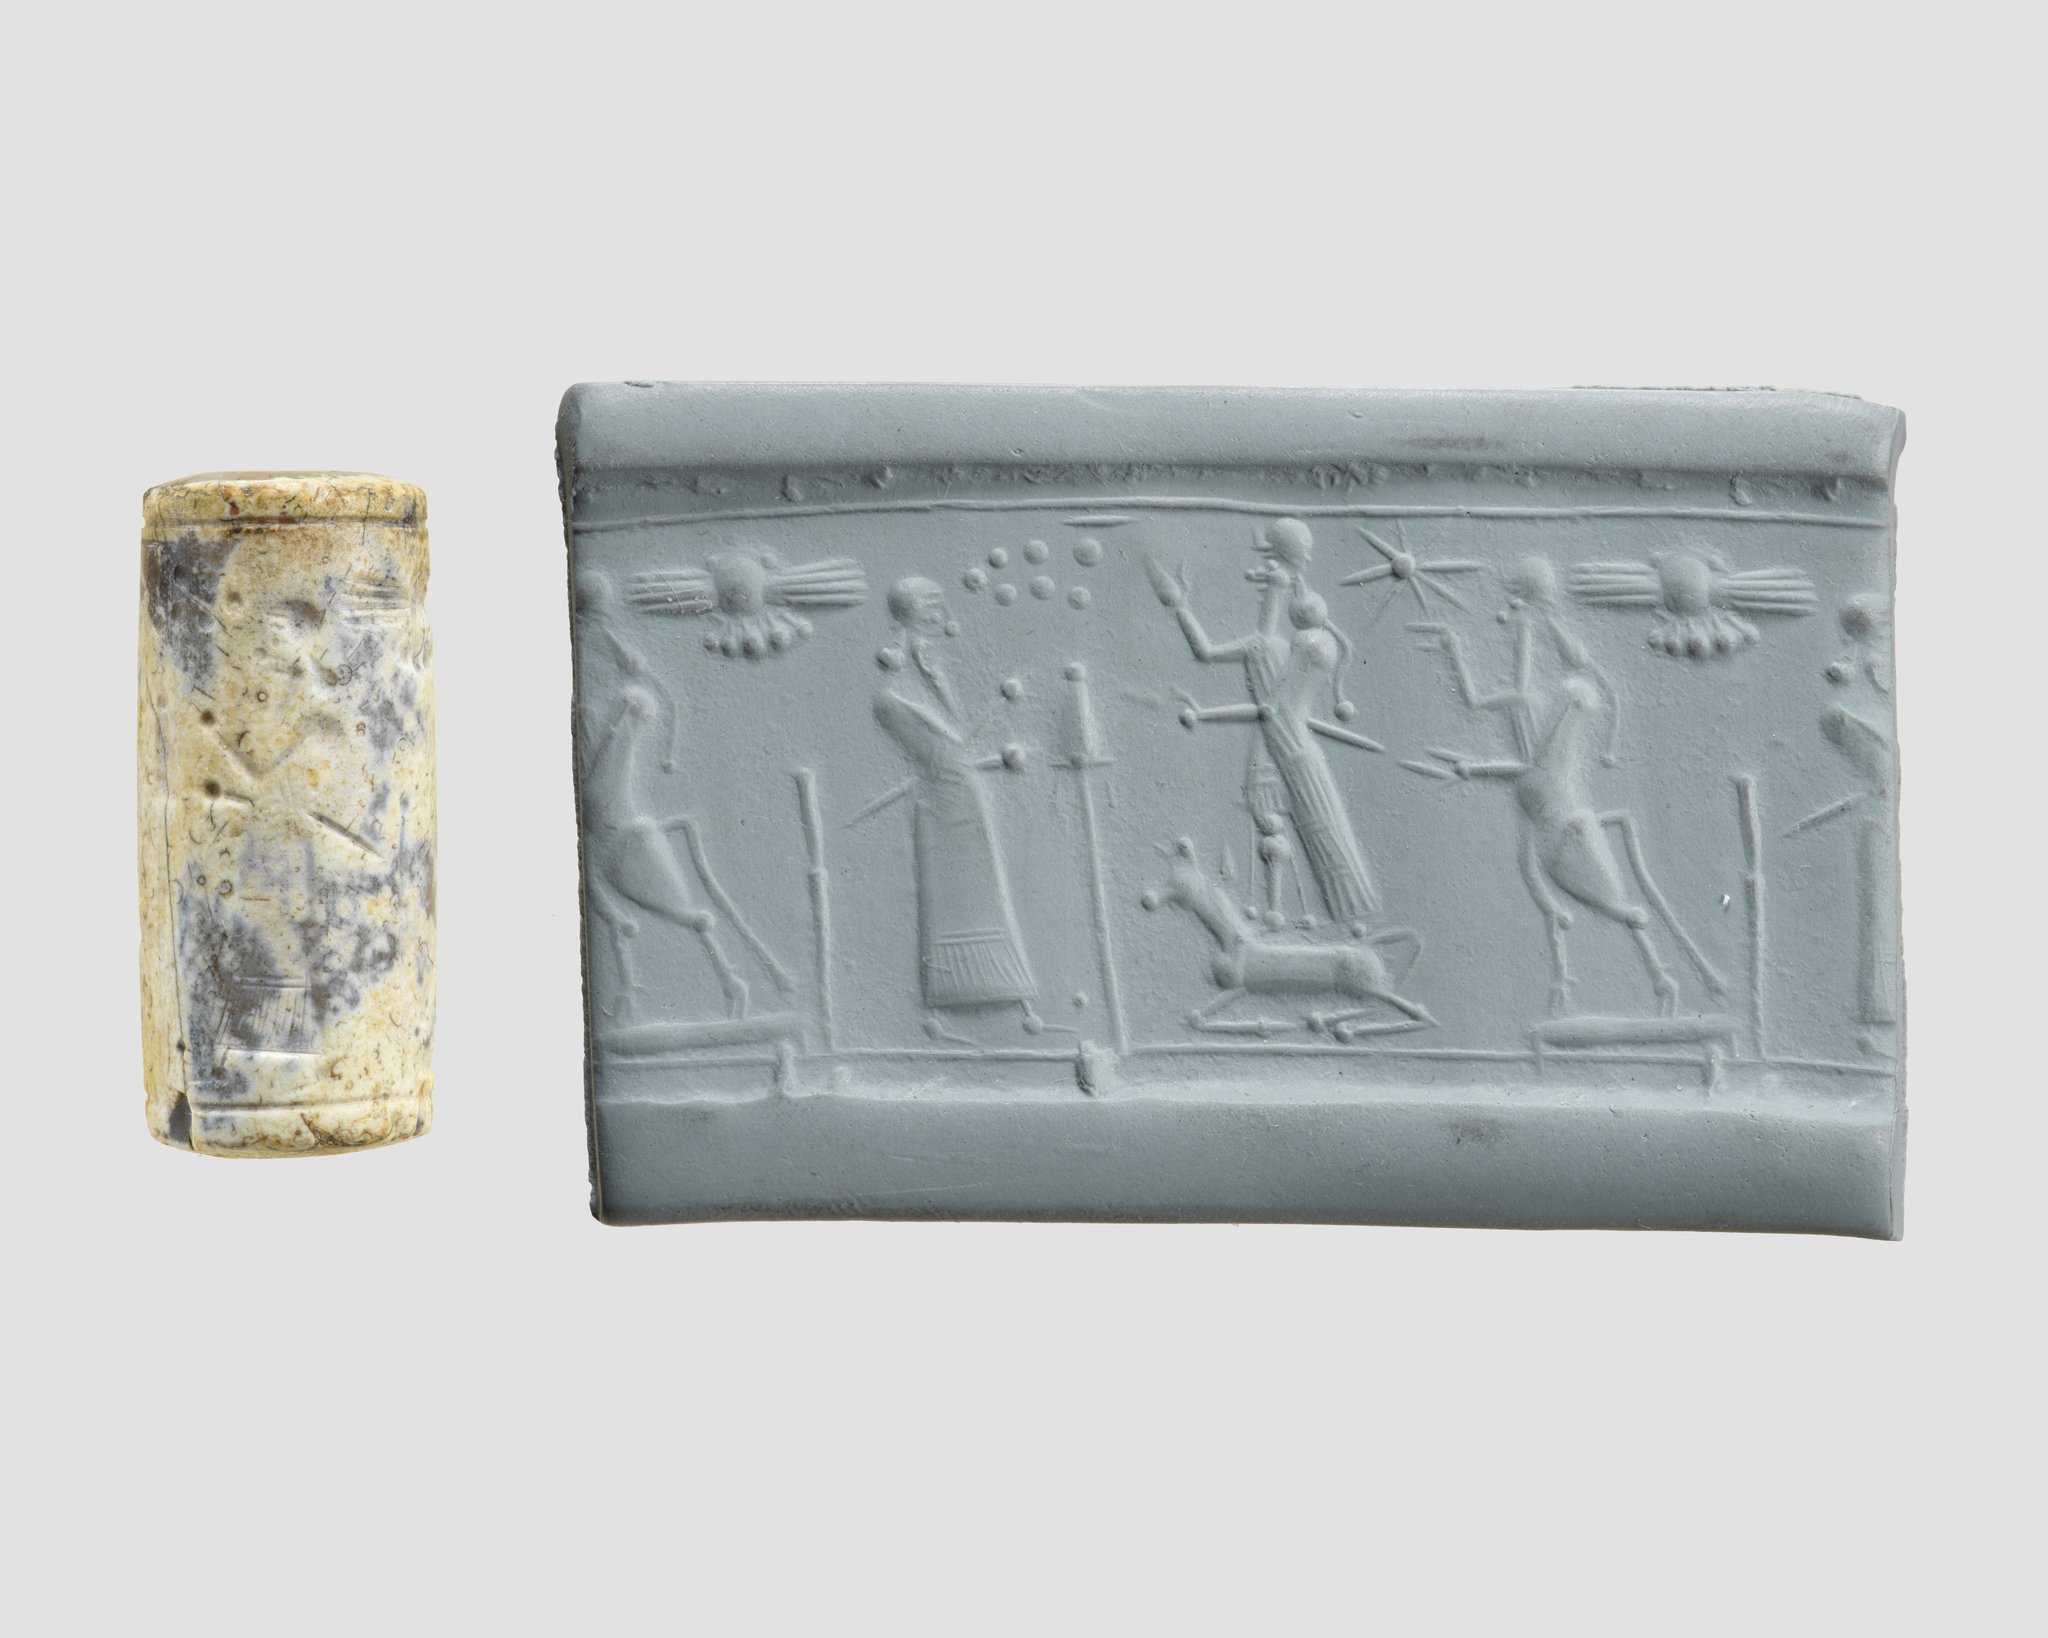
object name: cylinder seal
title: Cylinder seal with cultic scene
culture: assyro-babylonian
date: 734-601 BCE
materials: stone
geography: mesopotamia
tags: animals